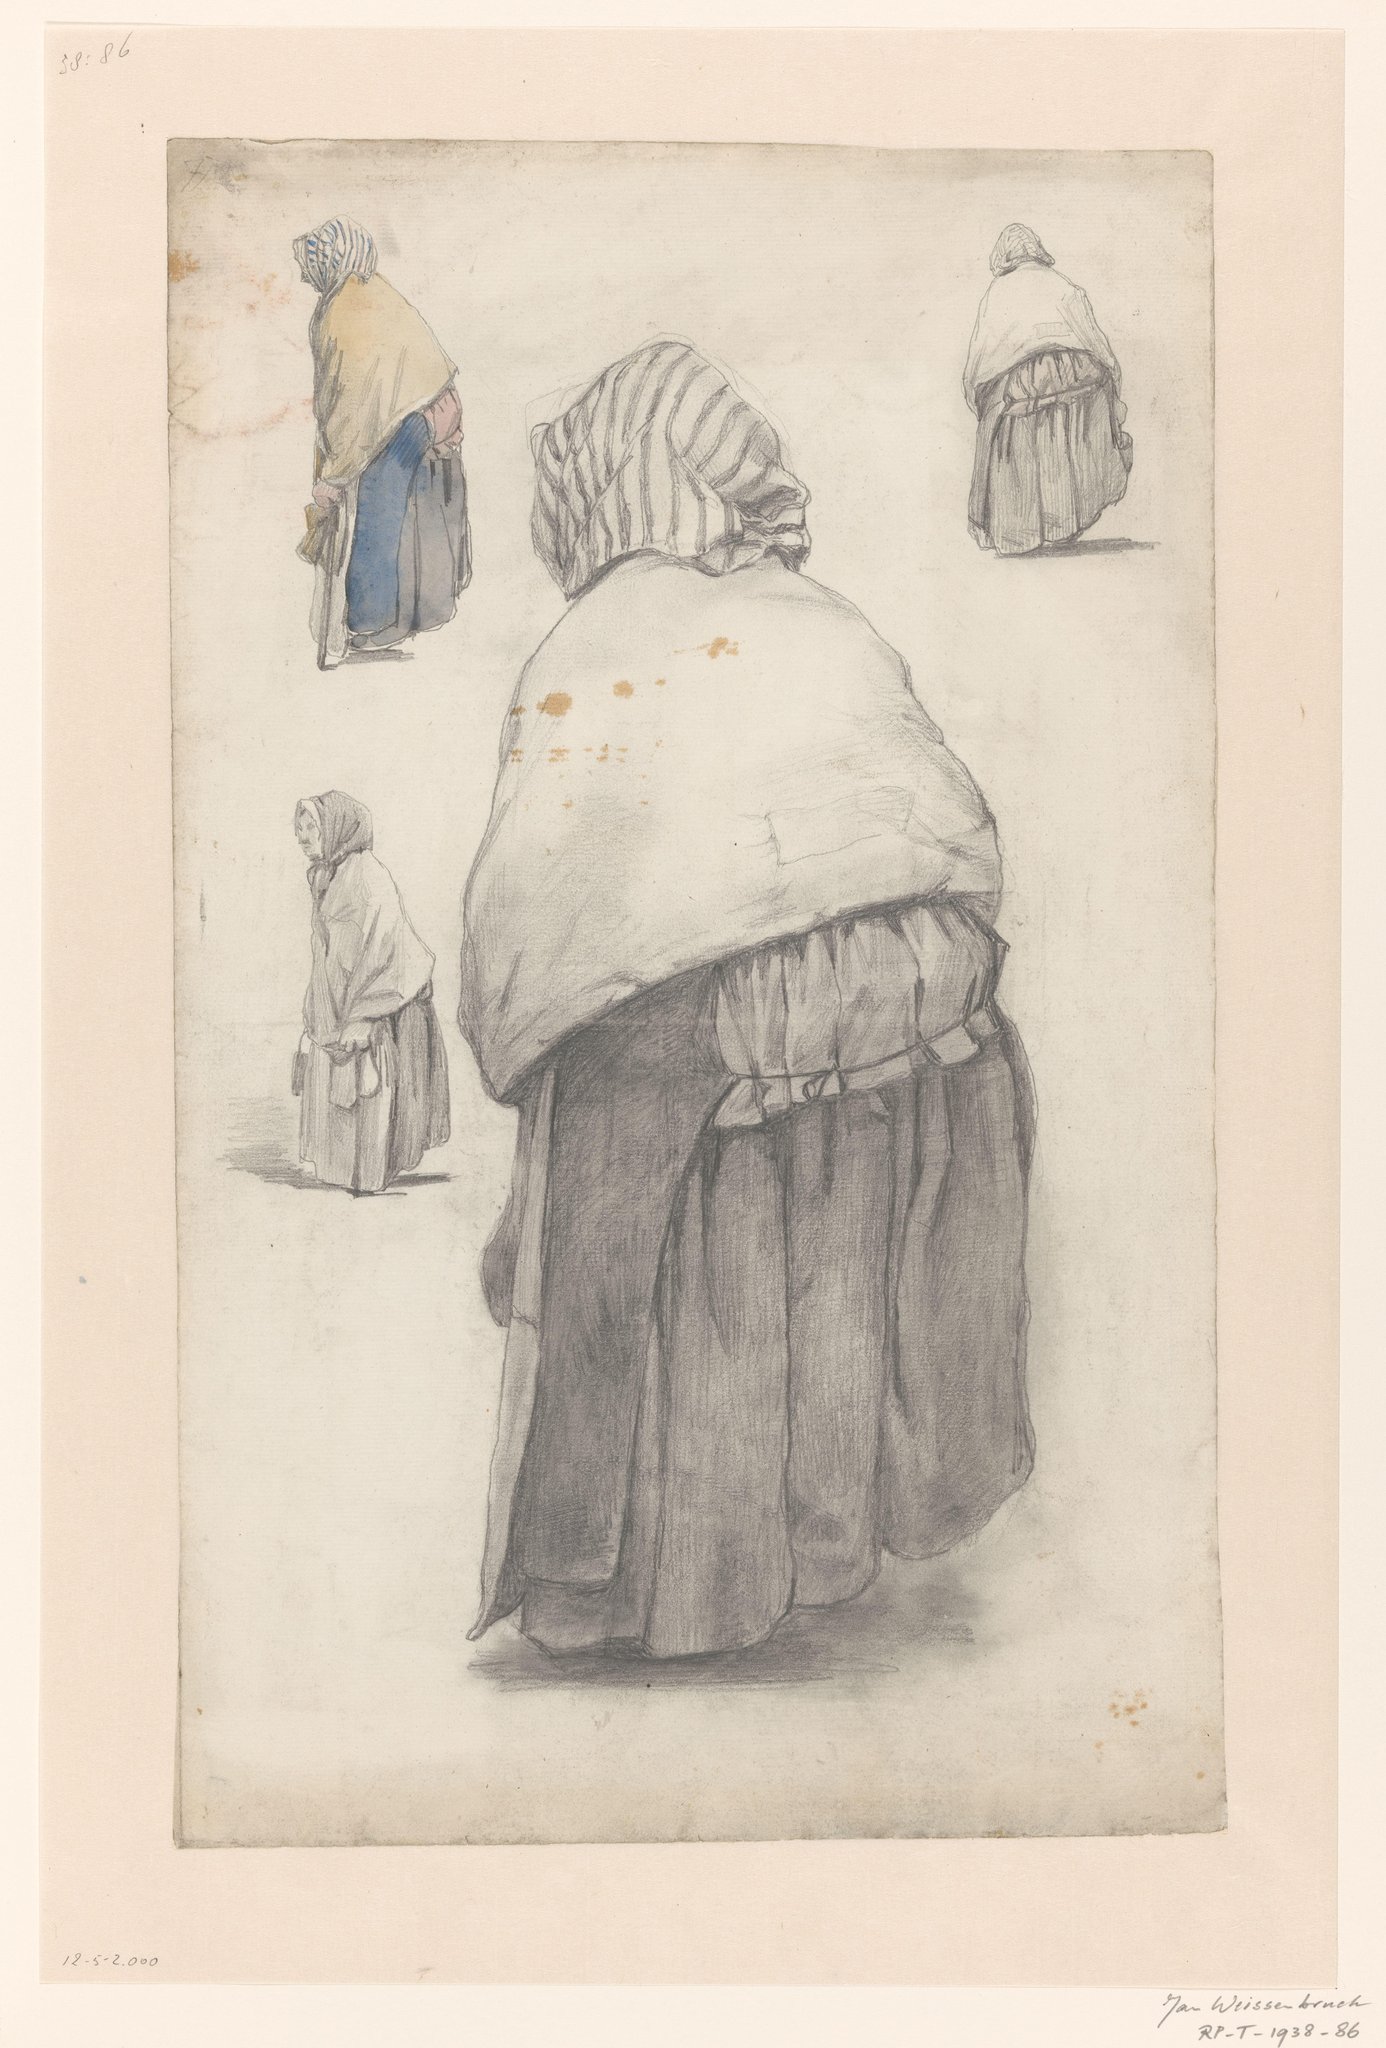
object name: watercolor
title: Studies van een oude vrouw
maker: jan weissenbruch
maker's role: painter, print maker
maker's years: 1822-1880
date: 1832-1880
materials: paper, pencil, watercolor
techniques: brush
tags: old woman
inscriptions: collector's mark: Lugt 2228